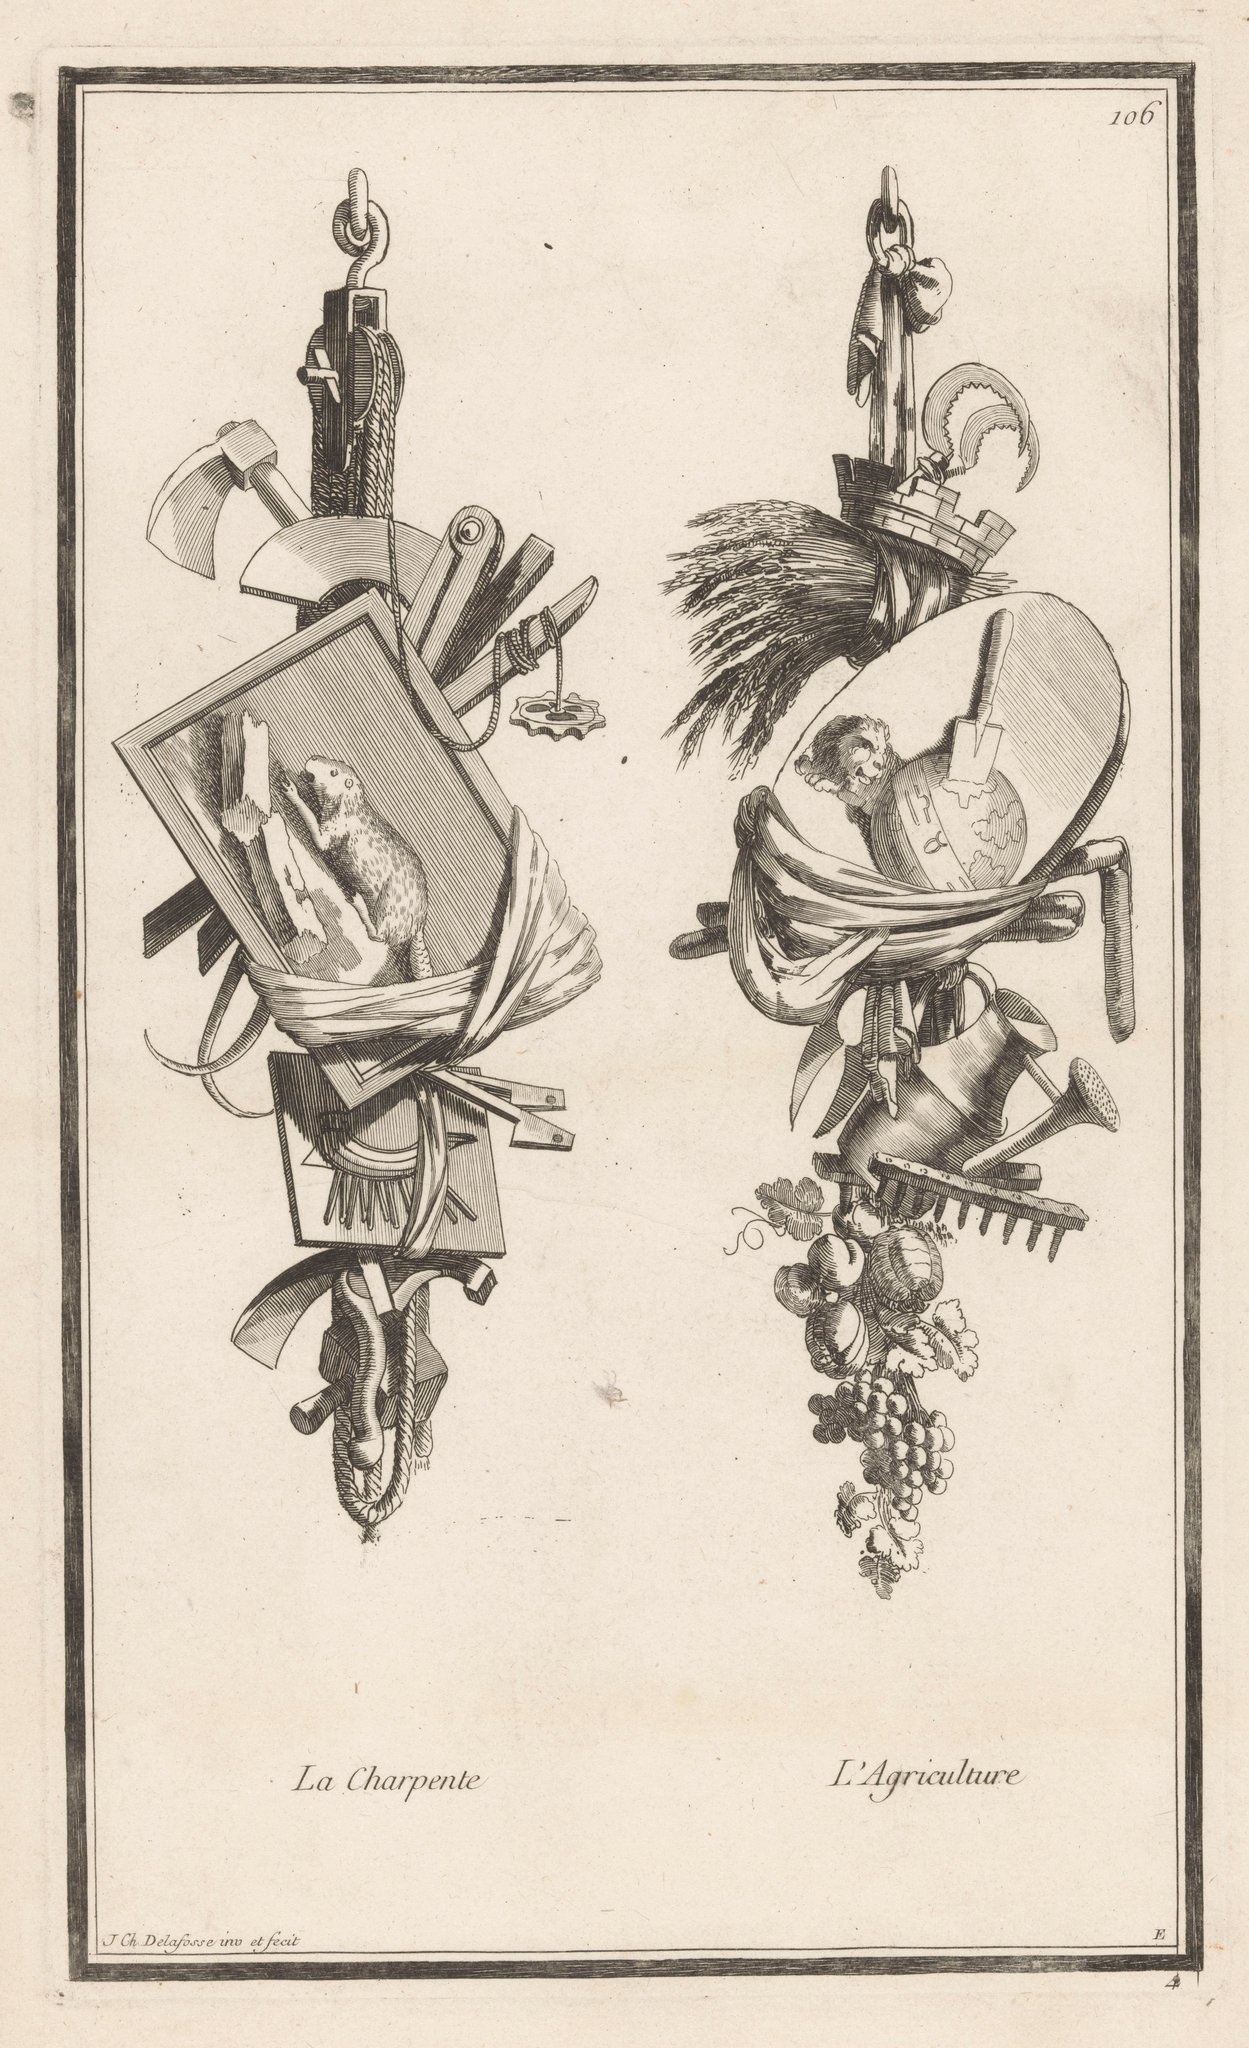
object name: print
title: Nouvelle Iconologie Historique Ou Attributs Hierogliphyques (...)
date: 1768-1771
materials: paper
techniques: engraving, etching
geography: paris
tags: trophy, i.e.: decorative arrangement of symbolic or typical objects ~ ornament, timber framing, agriculture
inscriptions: collector's mark: Lugt 2228, collector's mark: Lugt 2760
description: Links een trofee met attributen behorende bij raamwerken en een lijst met een bever. Rechts een trofee met attributen behorende bij agricultuur en een medaillon met een globe met schep en leeuw. Prentnummer 106.